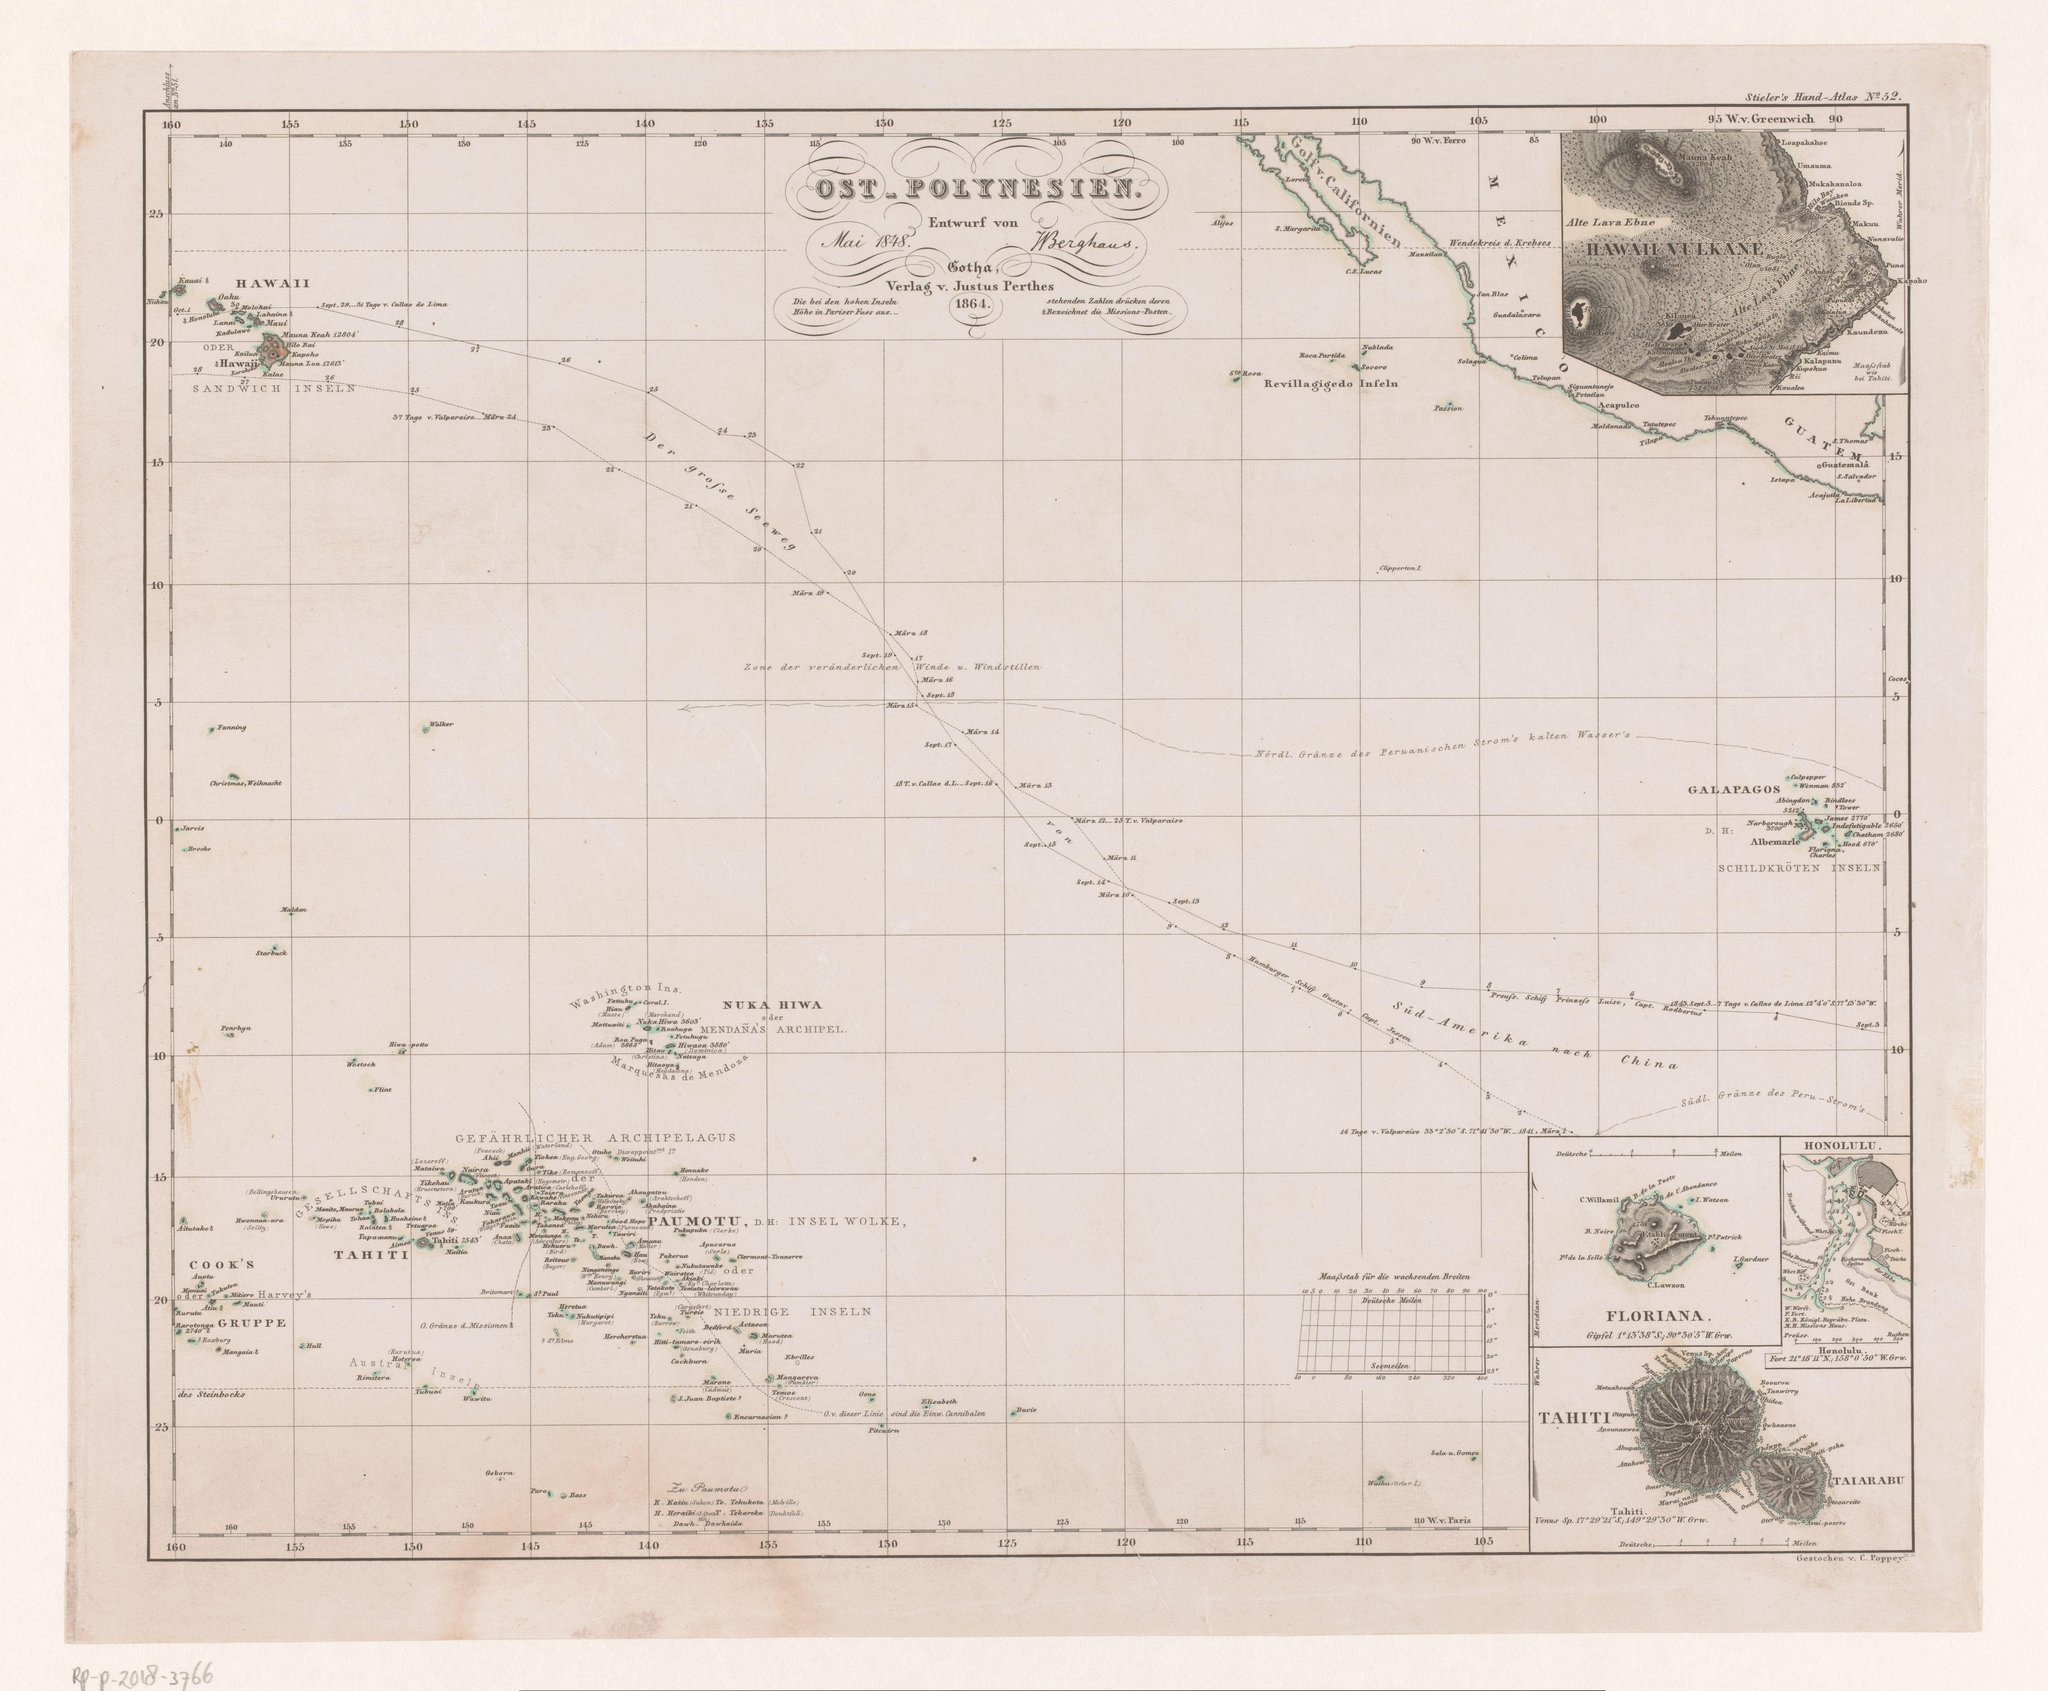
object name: map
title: Ost-Polynesien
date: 1864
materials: paper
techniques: engraving, etching, hand coloring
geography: gotha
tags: maps, atlases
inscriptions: collector's mark: Lugt 2228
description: Prent uit: Stielers Handatlas. Gotha: Uitgeverij Justus Perthes, 1864, dl. 4.